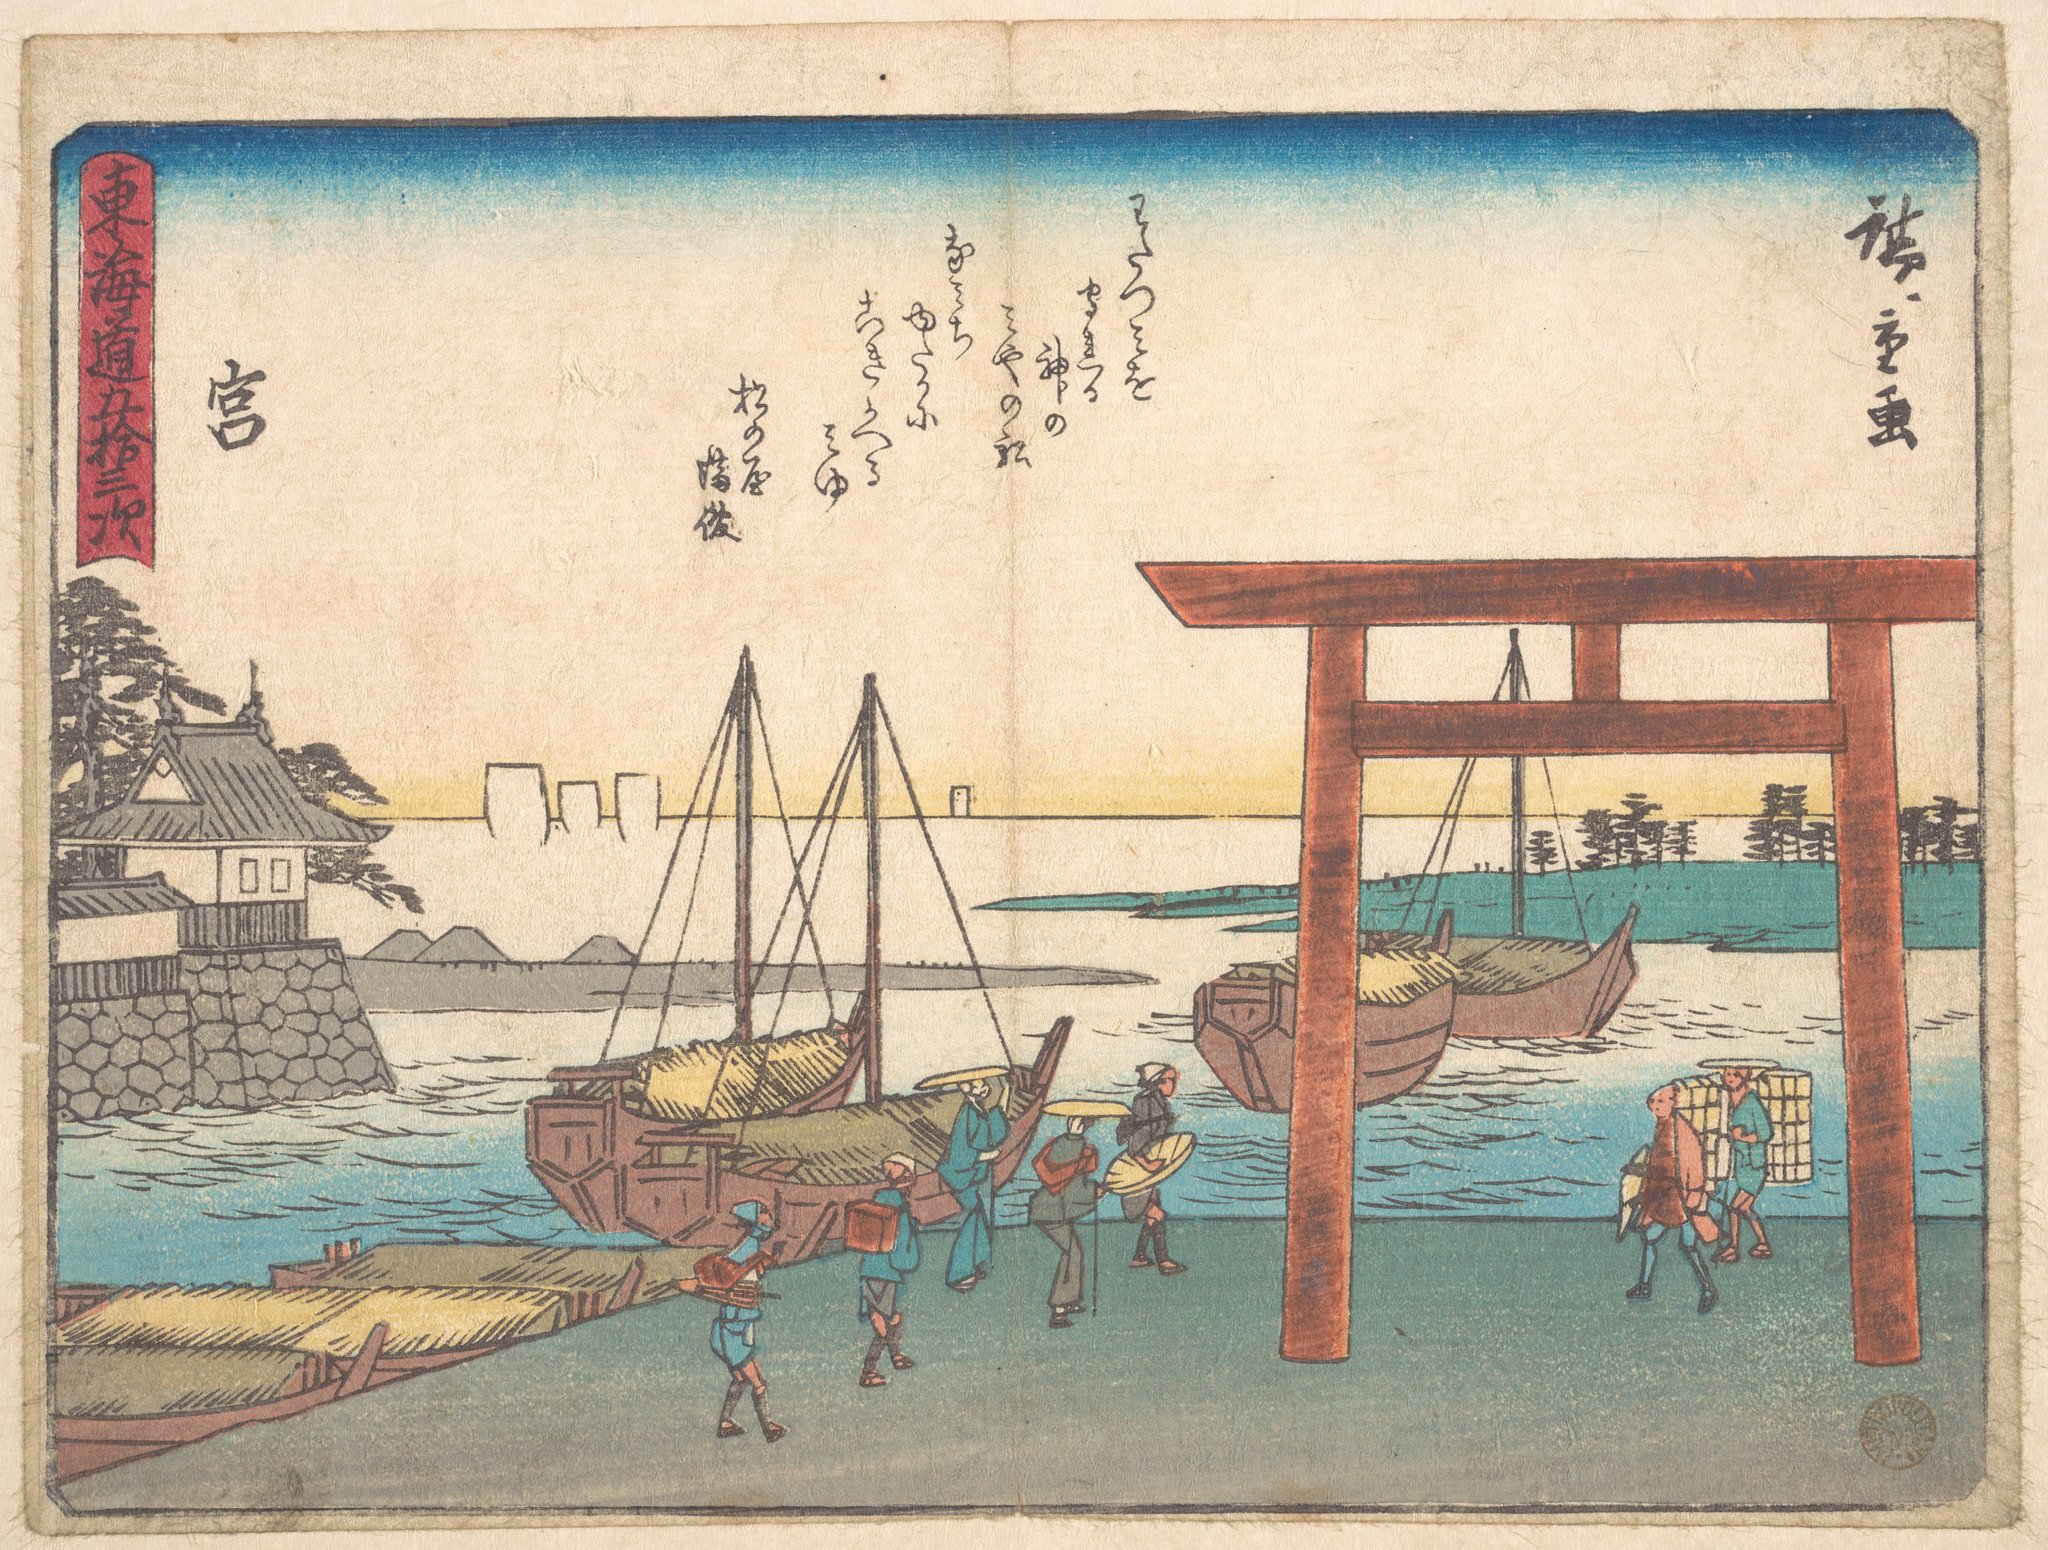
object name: print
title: Miya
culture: japanese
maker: utagawa hiroshige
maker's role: artist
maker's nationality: japanese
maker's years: 1797-1858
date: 1838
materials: ink, paper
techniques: woodblock print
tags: human figures,gates,boats